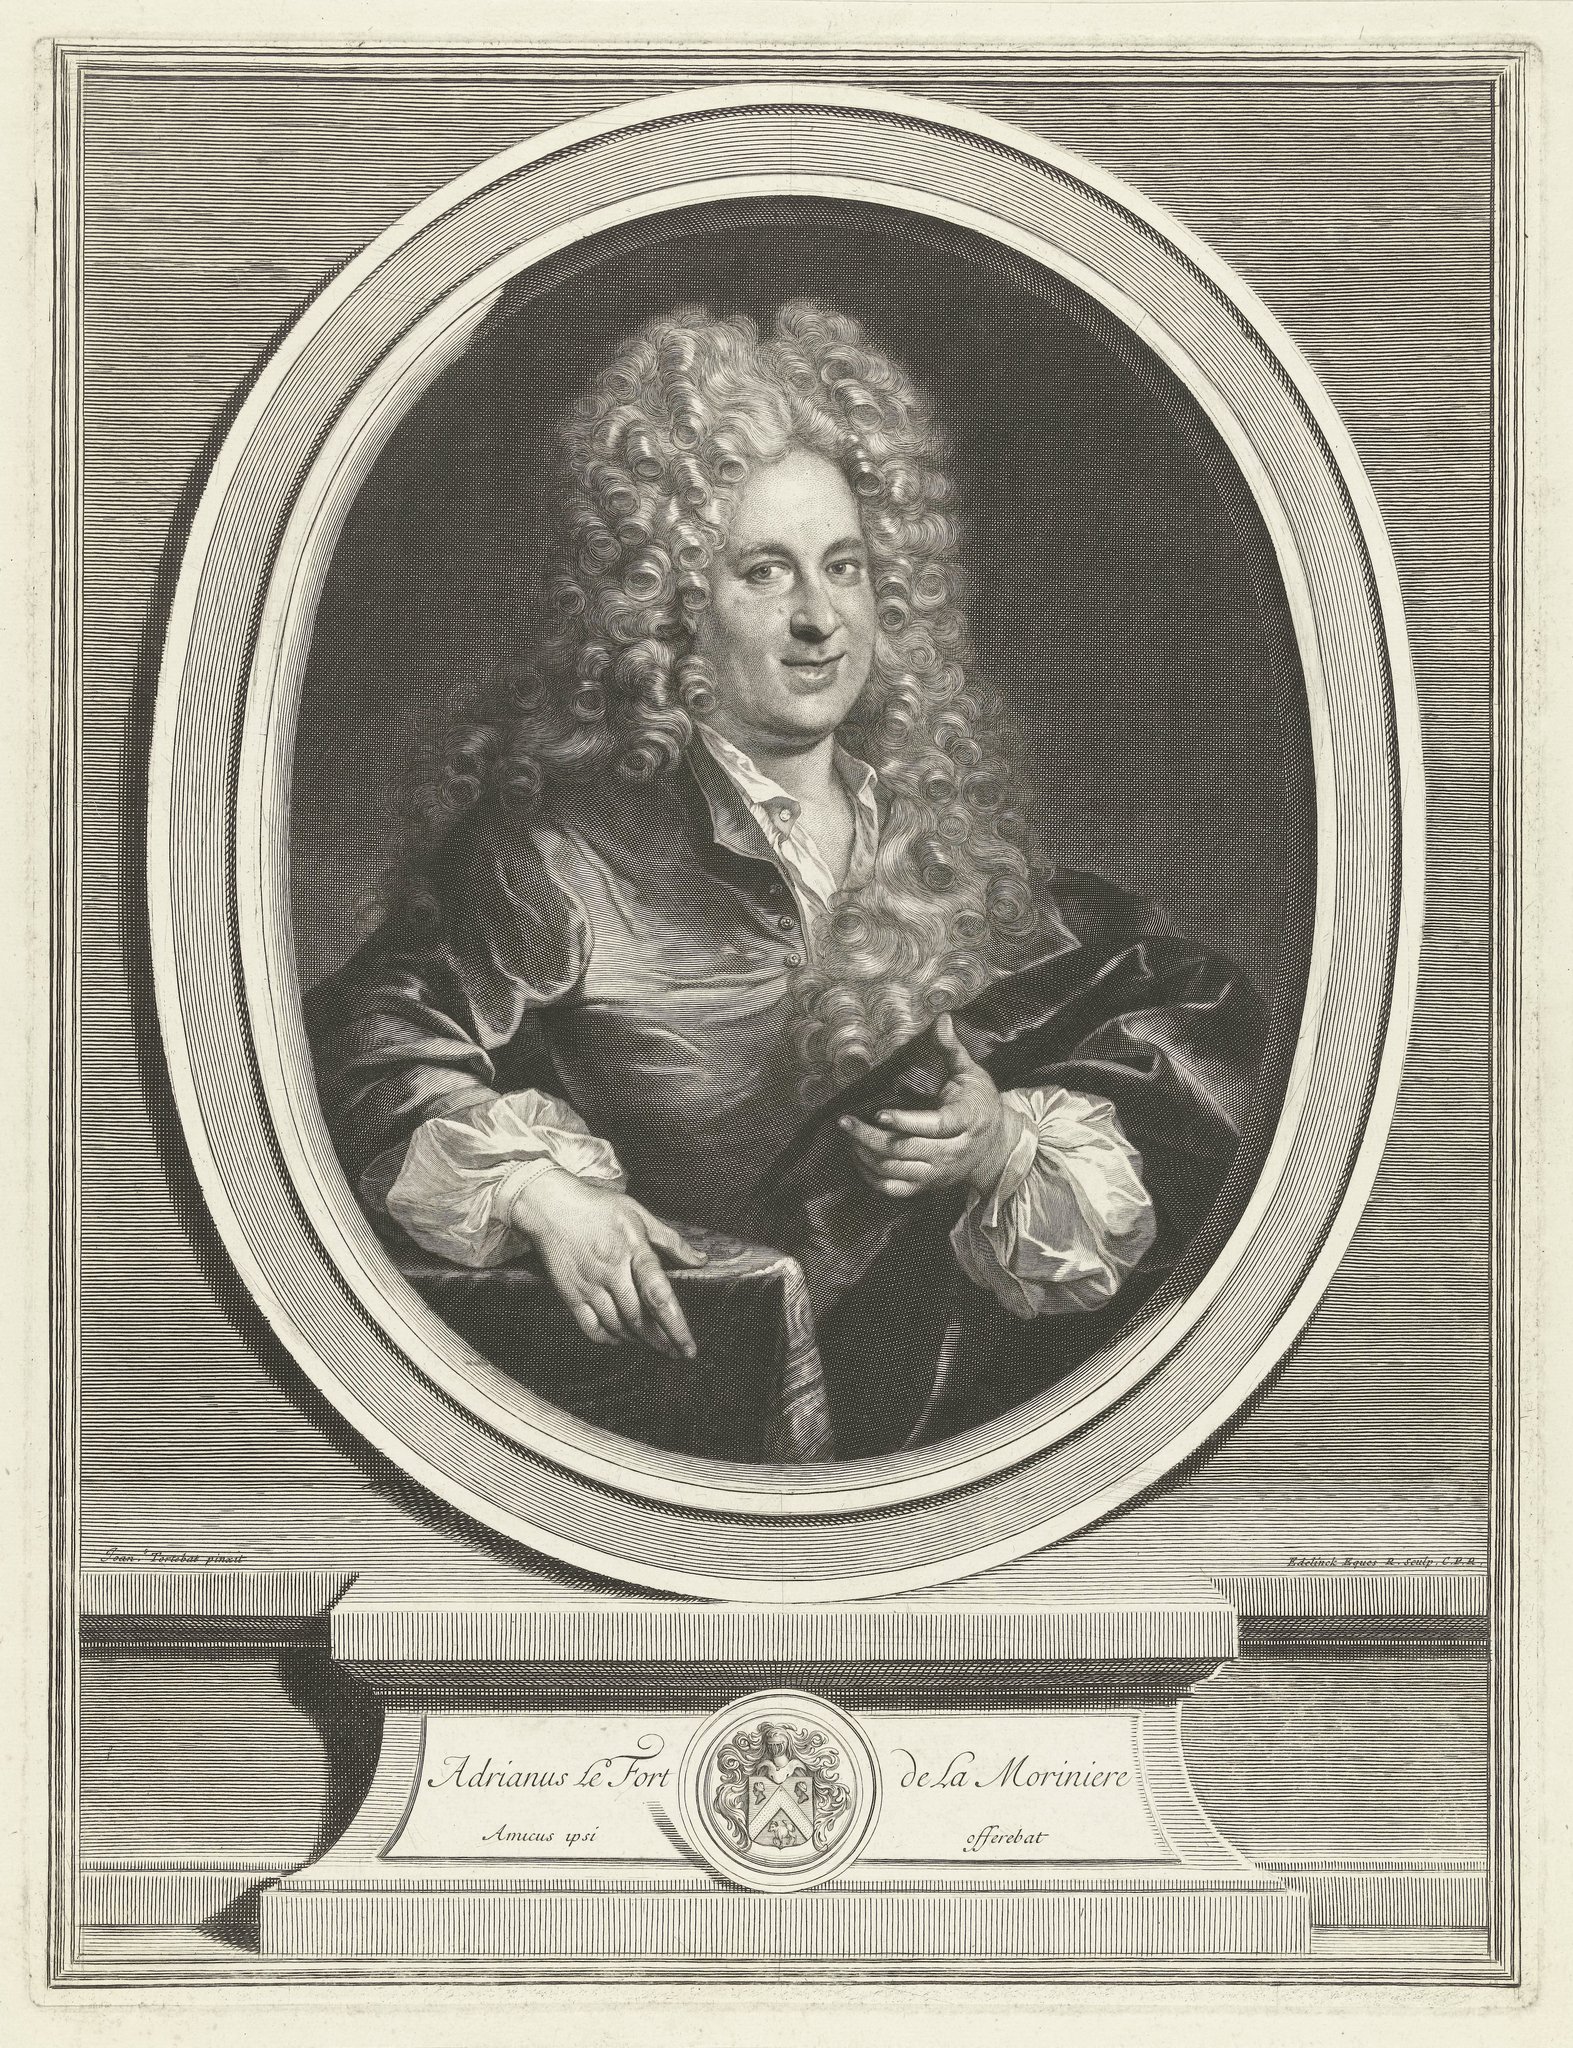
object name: print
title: Adrianus le Fort de la Moriniere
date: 1666-1707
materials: paper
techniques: engraving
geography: paris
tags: adrien lefort de la morinière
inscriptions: collector's mark: Lugt 240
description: Portret van Adrien Lefort de la Morinière, afgebeeld in ovale omlijsting waaronder een console met wapen.